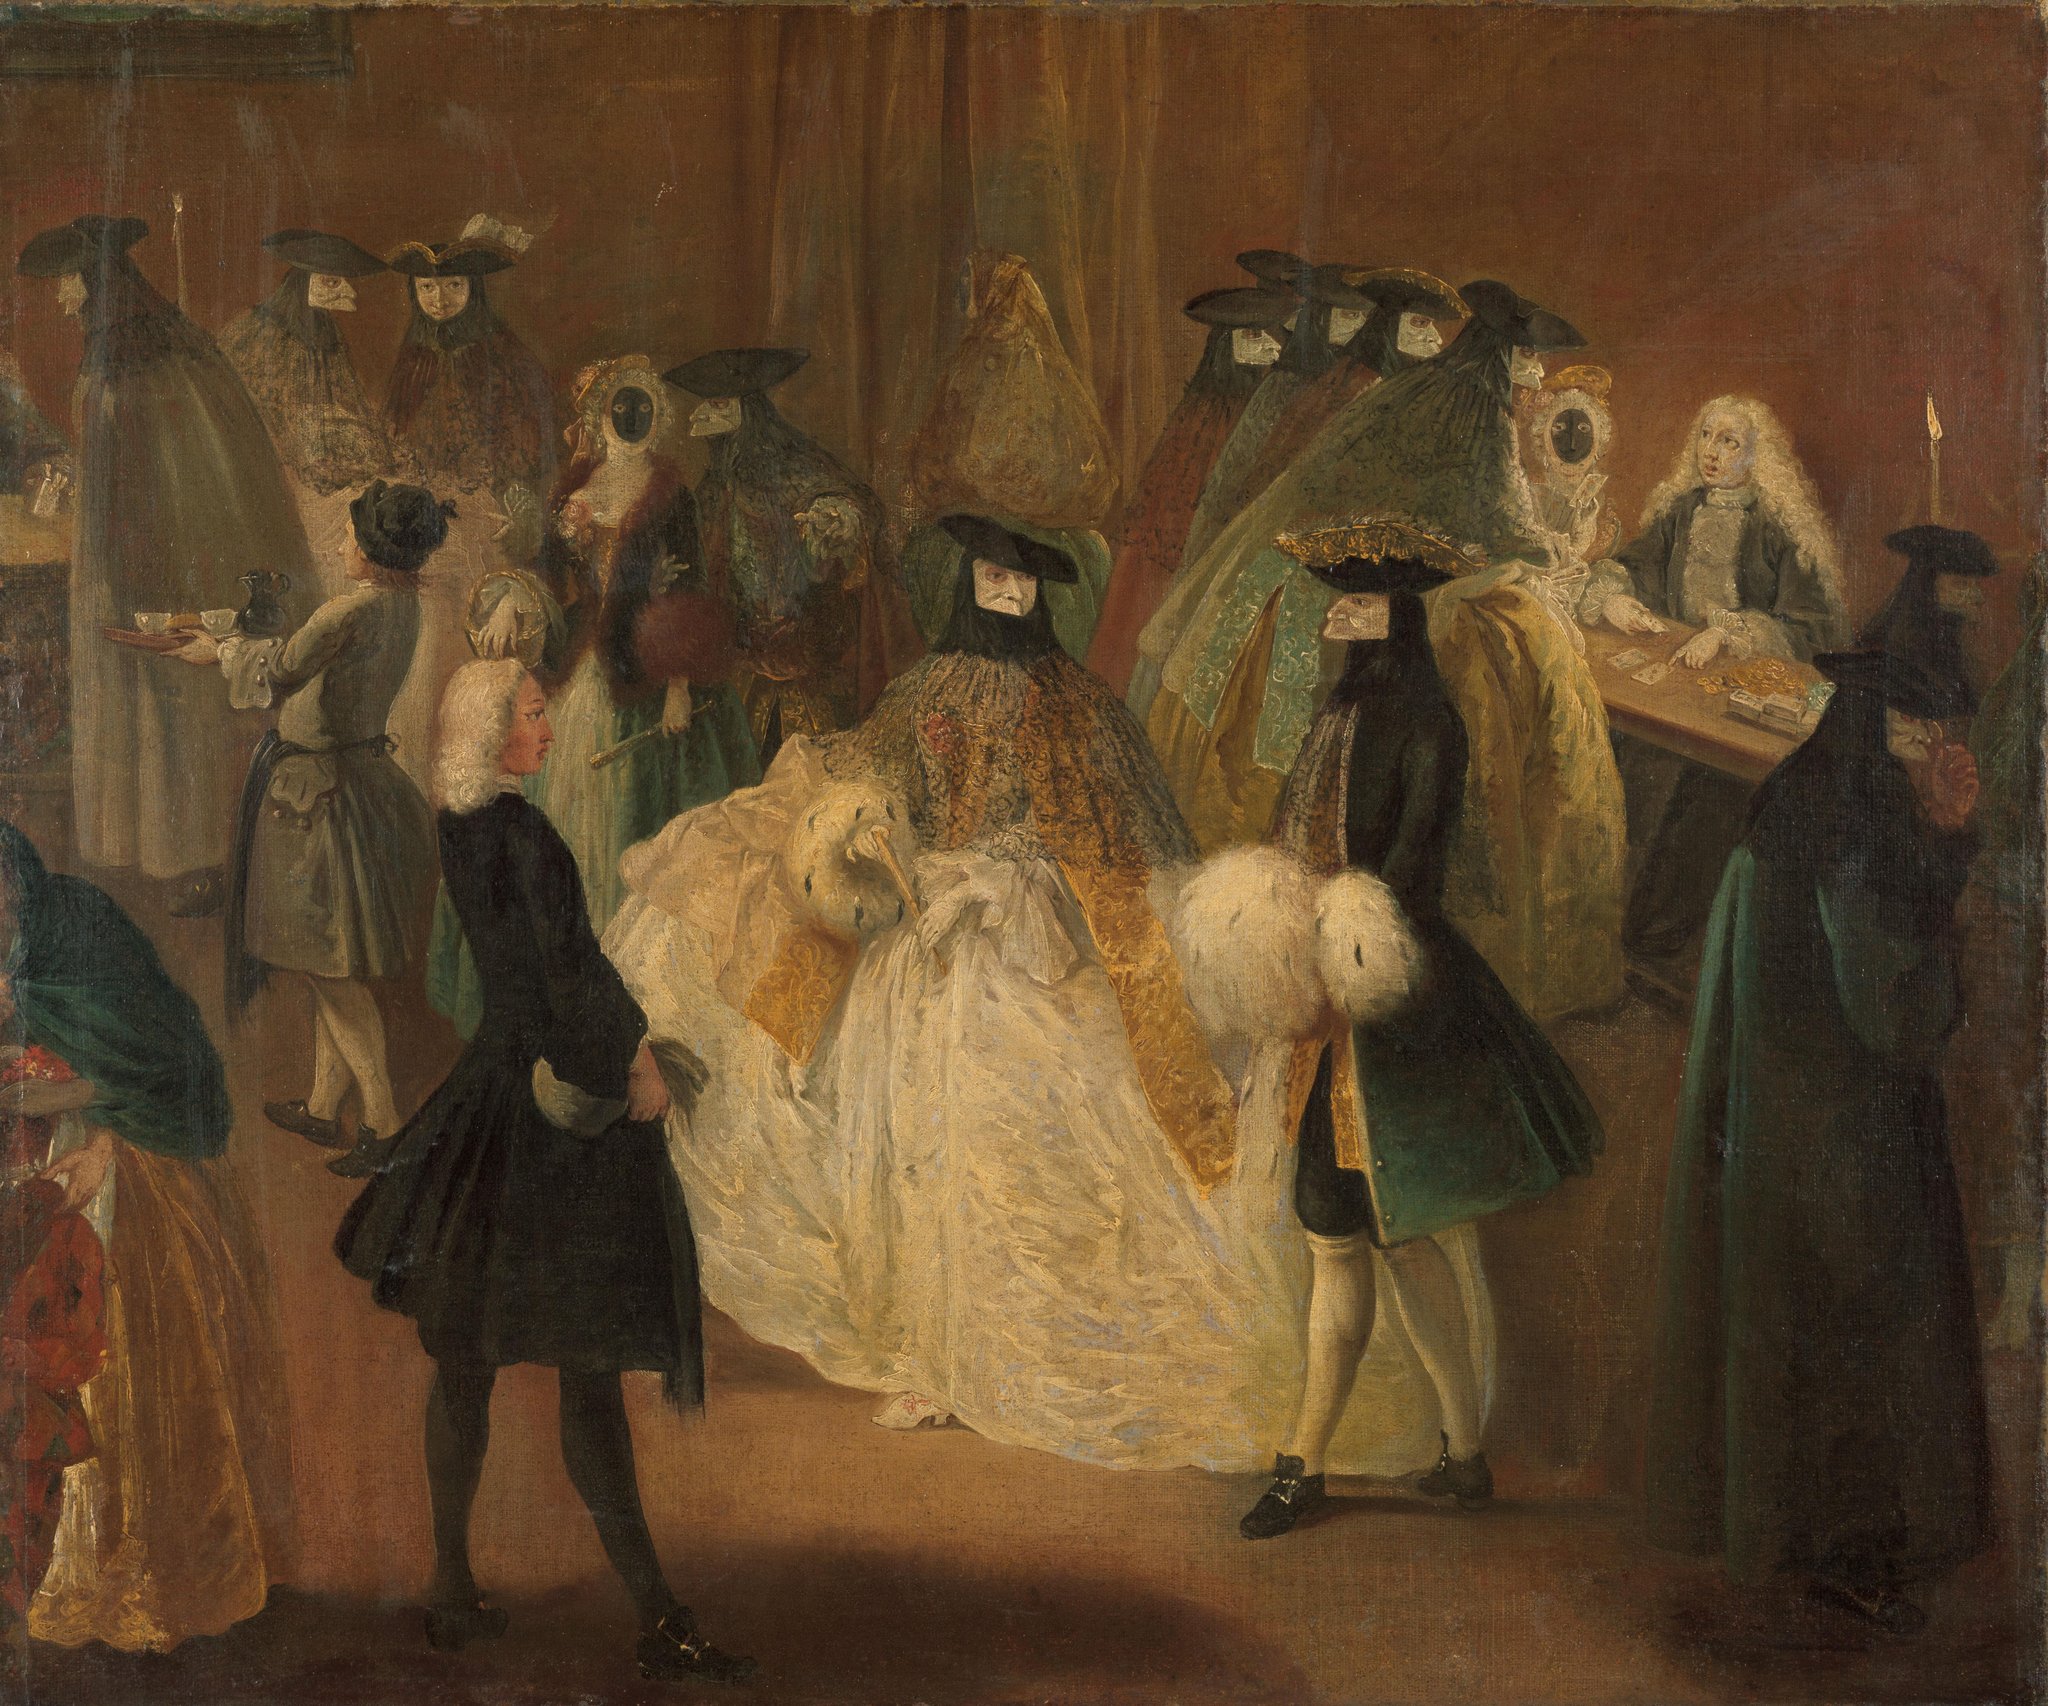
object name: fragment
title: The Casino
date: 1720-1790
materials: canvas, oil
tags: mask, masquerade, masked ball, carnival, shrovetide (non-liturgical celebration), casino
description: De speelbank. Met kaarsen verlicht interieur waarin groepen gemaskerde en elegant geklede heren en dames zich vermaken met gokspelletjes.